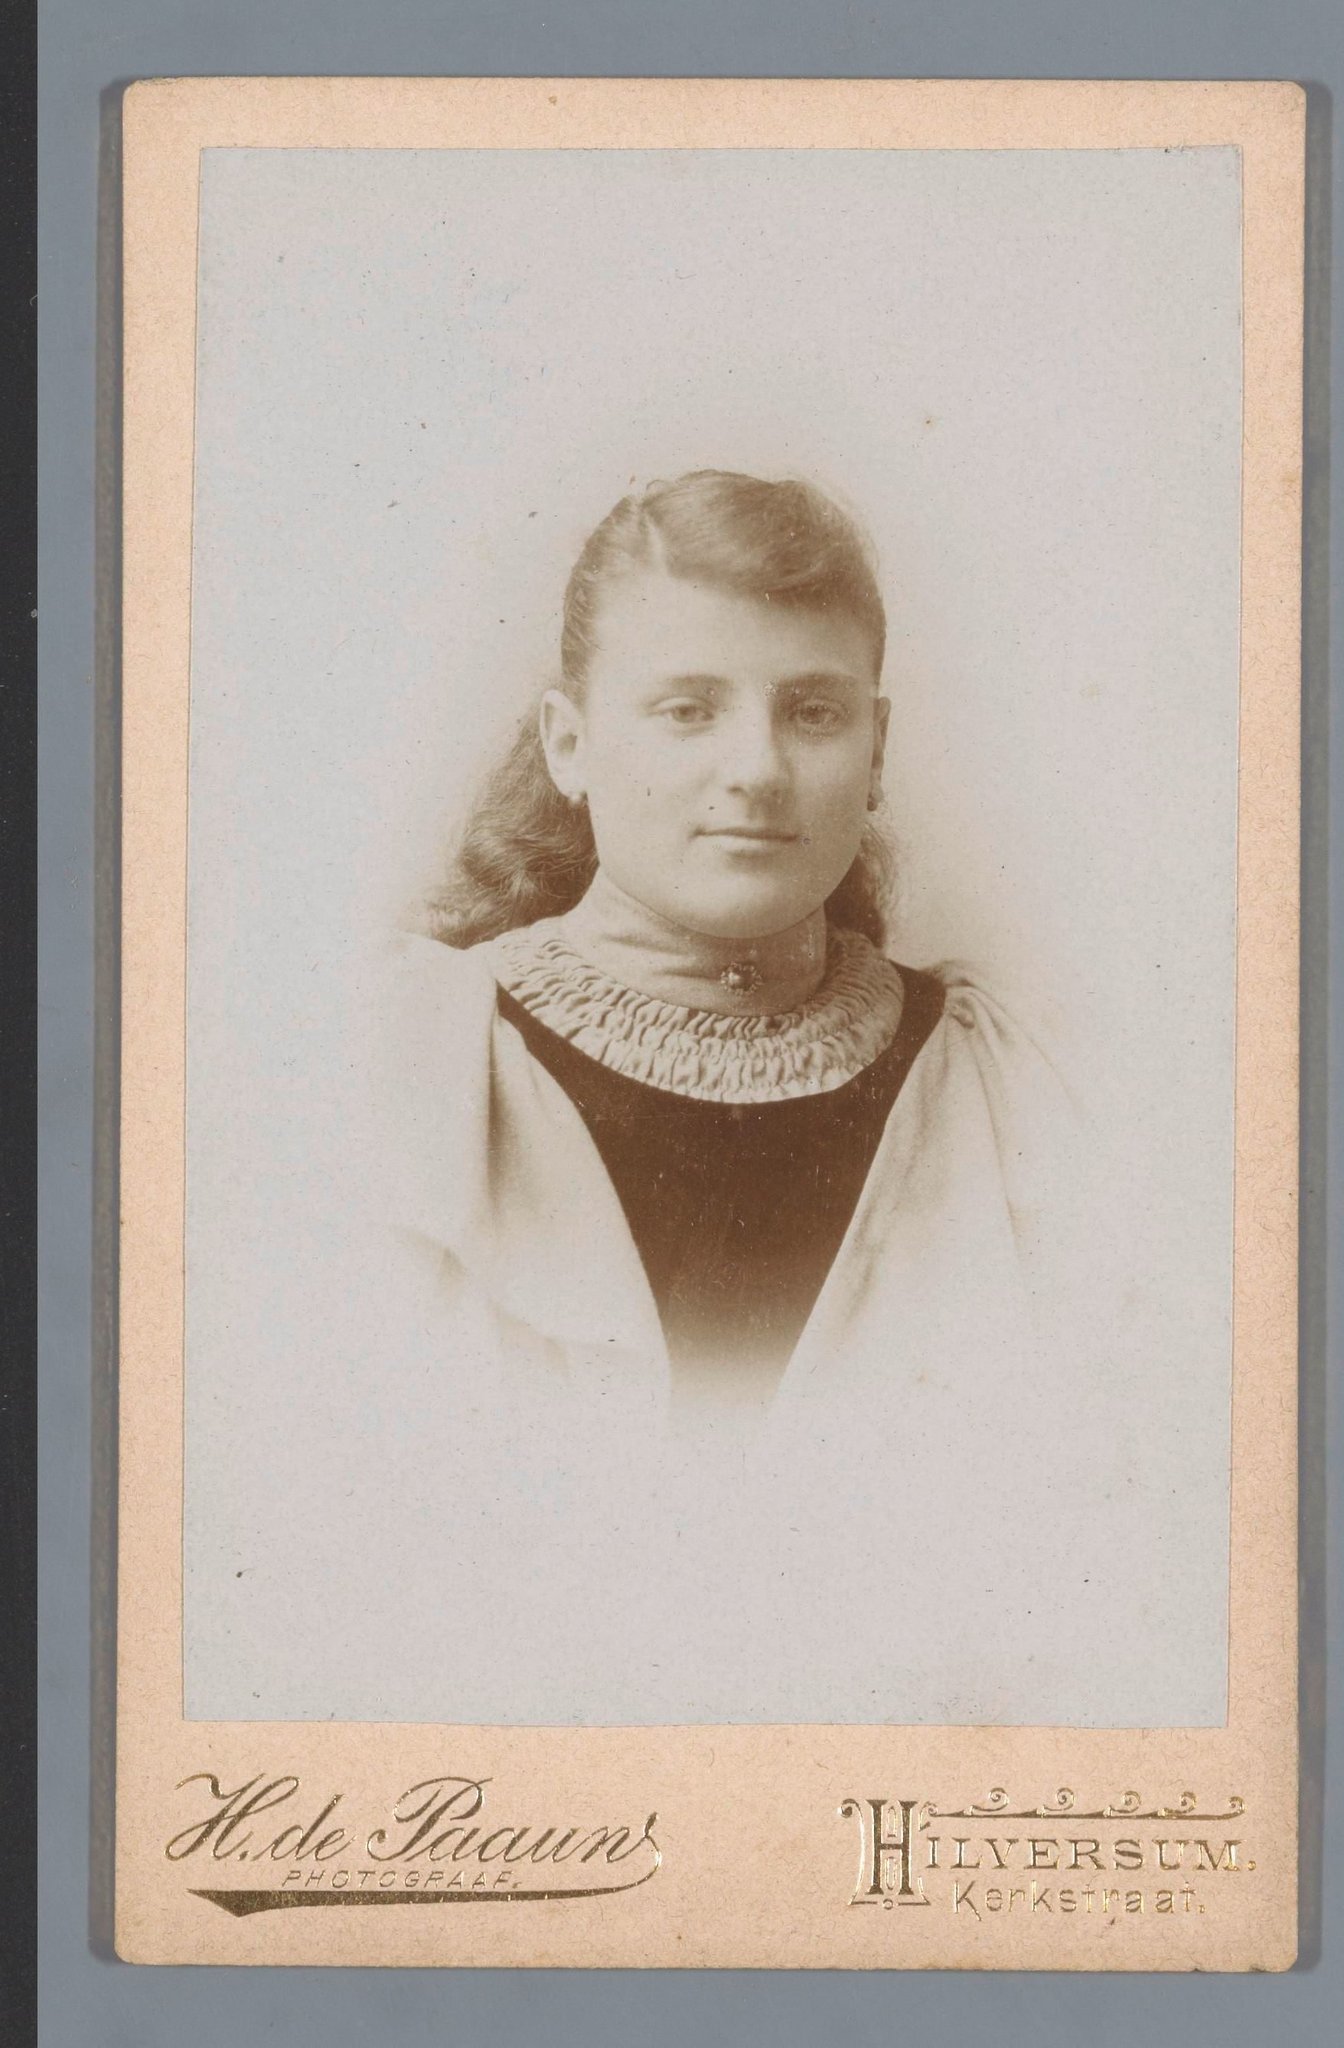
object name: carte de visite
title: Portret van een onbekende vrouw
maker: henri de paauw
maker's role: fotograaf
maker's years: 1849-1922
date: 1882-1903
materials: cardboard, paper, photographic support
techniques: daylight paper print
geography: hilversum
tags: adolescent, young woman, maiden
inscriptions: name: ‘H. de Paauw Photograaf. Hilversum. Kerstraat.’